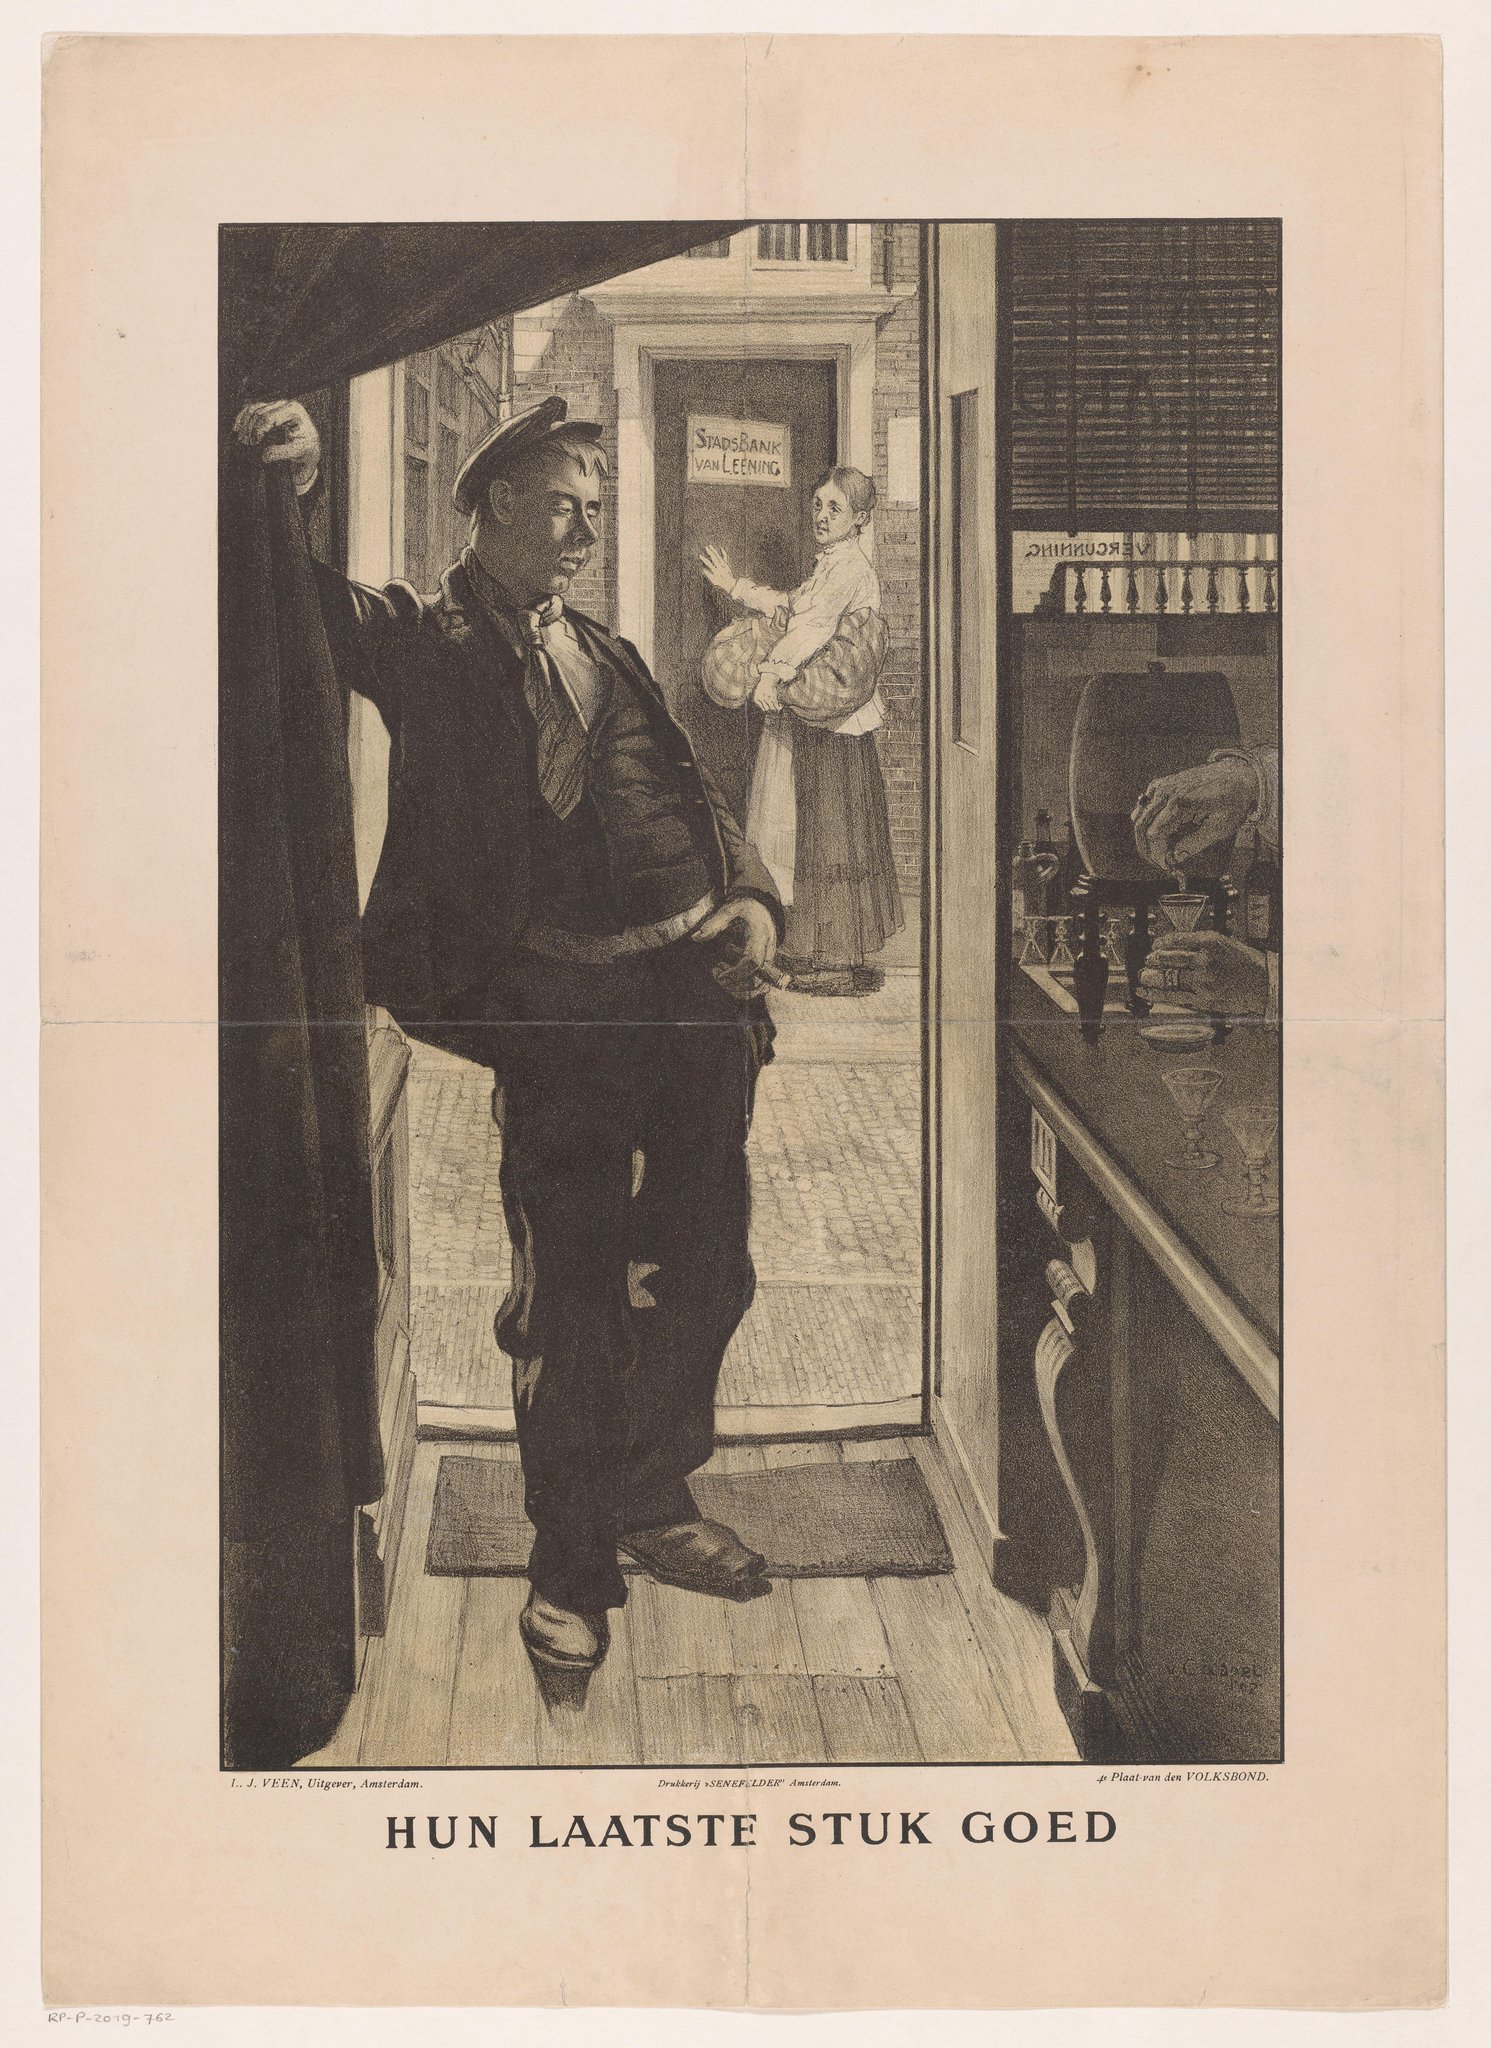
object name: poster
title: Hun laatste stuk goed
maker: johann georg van caspel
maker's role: draughtsman, print maker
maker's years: 1870-1928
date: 1902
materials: paper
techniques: lithograph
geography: amsterdam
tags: alcoholism, the poor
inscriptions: collector's mark: Lugt 2228a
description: Een man staat in een kroeg bij de deuropening waar hij wacht op zijn bestelling. In de achtergrond brengt zijn vrouw een pakket naar de tegenoverliggende Bank van Leening.